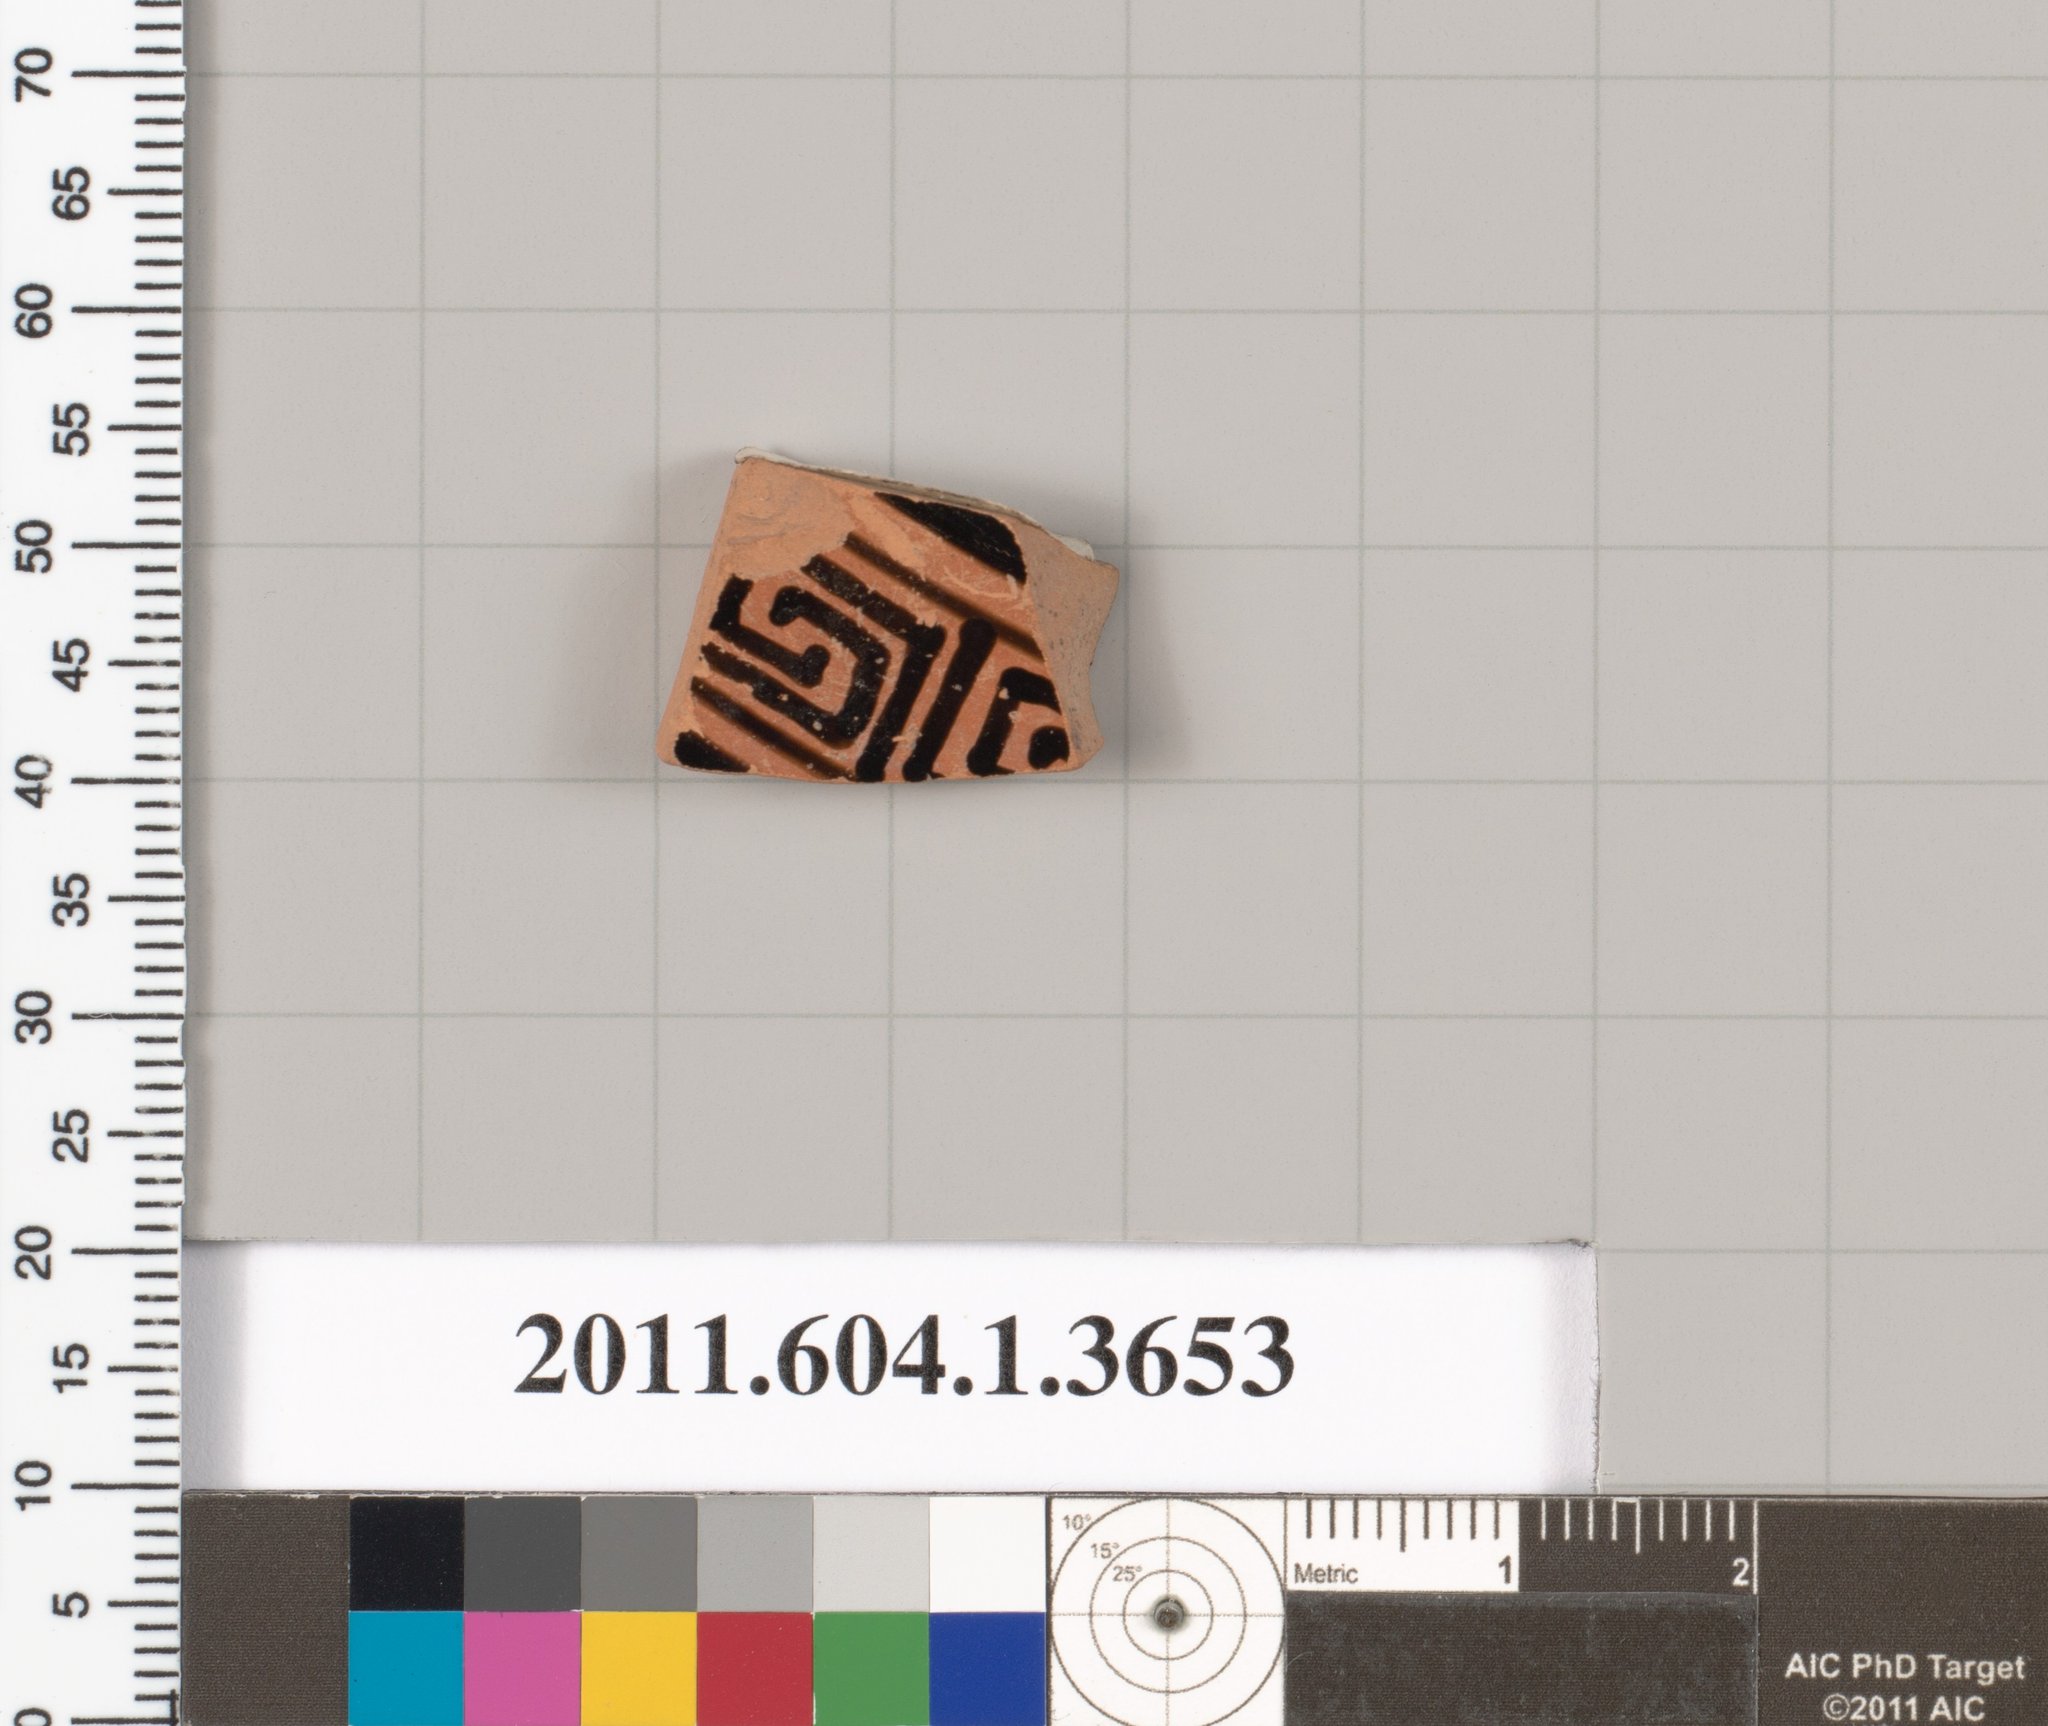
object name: kylix fragment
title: Terracotta fragment of a kylix (drinking cup)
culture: greek, attic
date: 500-470 BCE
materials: terracotta